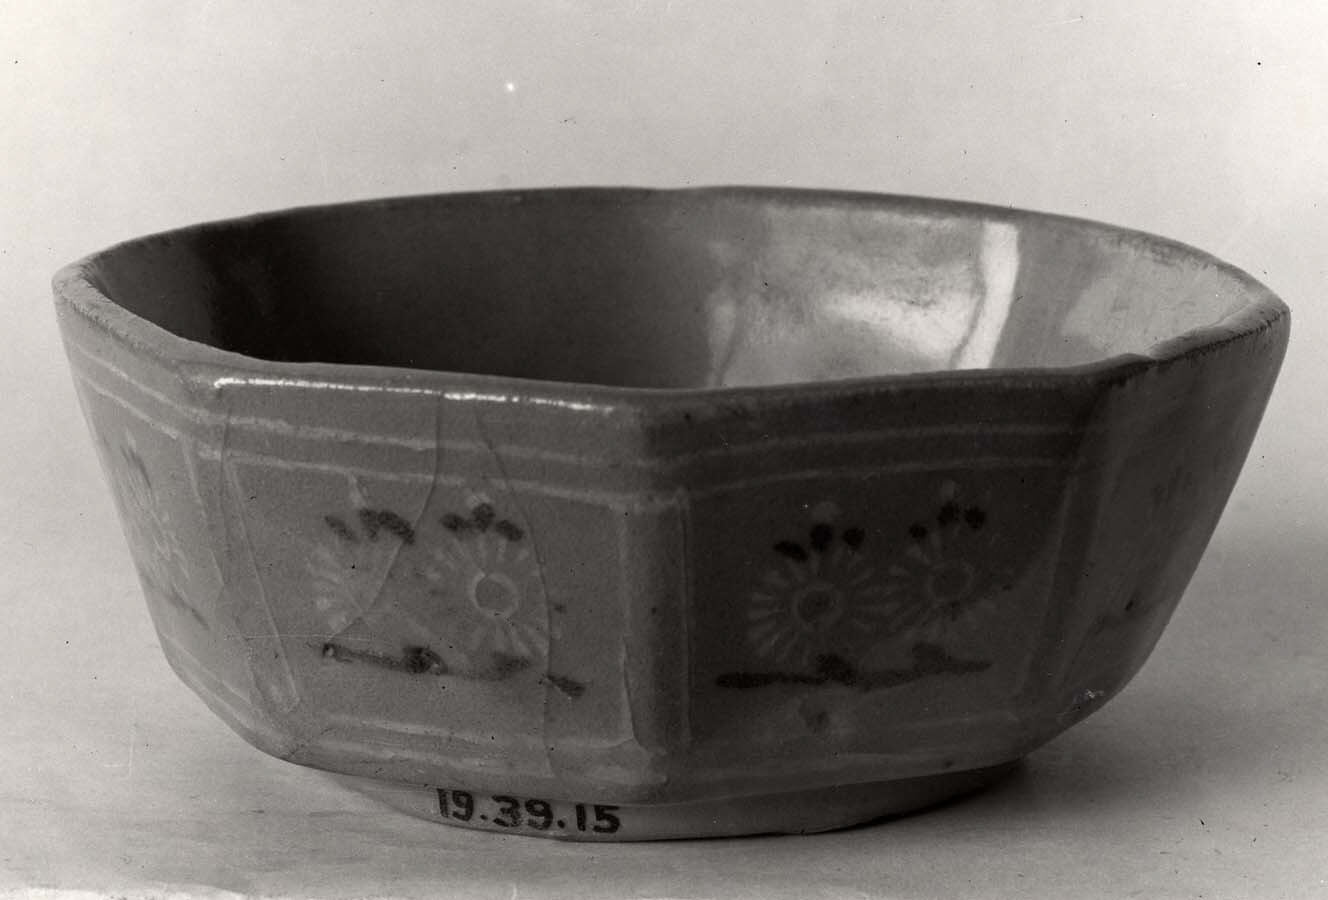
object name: dish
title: Octagonal Dish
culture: korean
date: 1201-1300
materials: ceramic glaze, glaze, stoneware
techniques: inlay